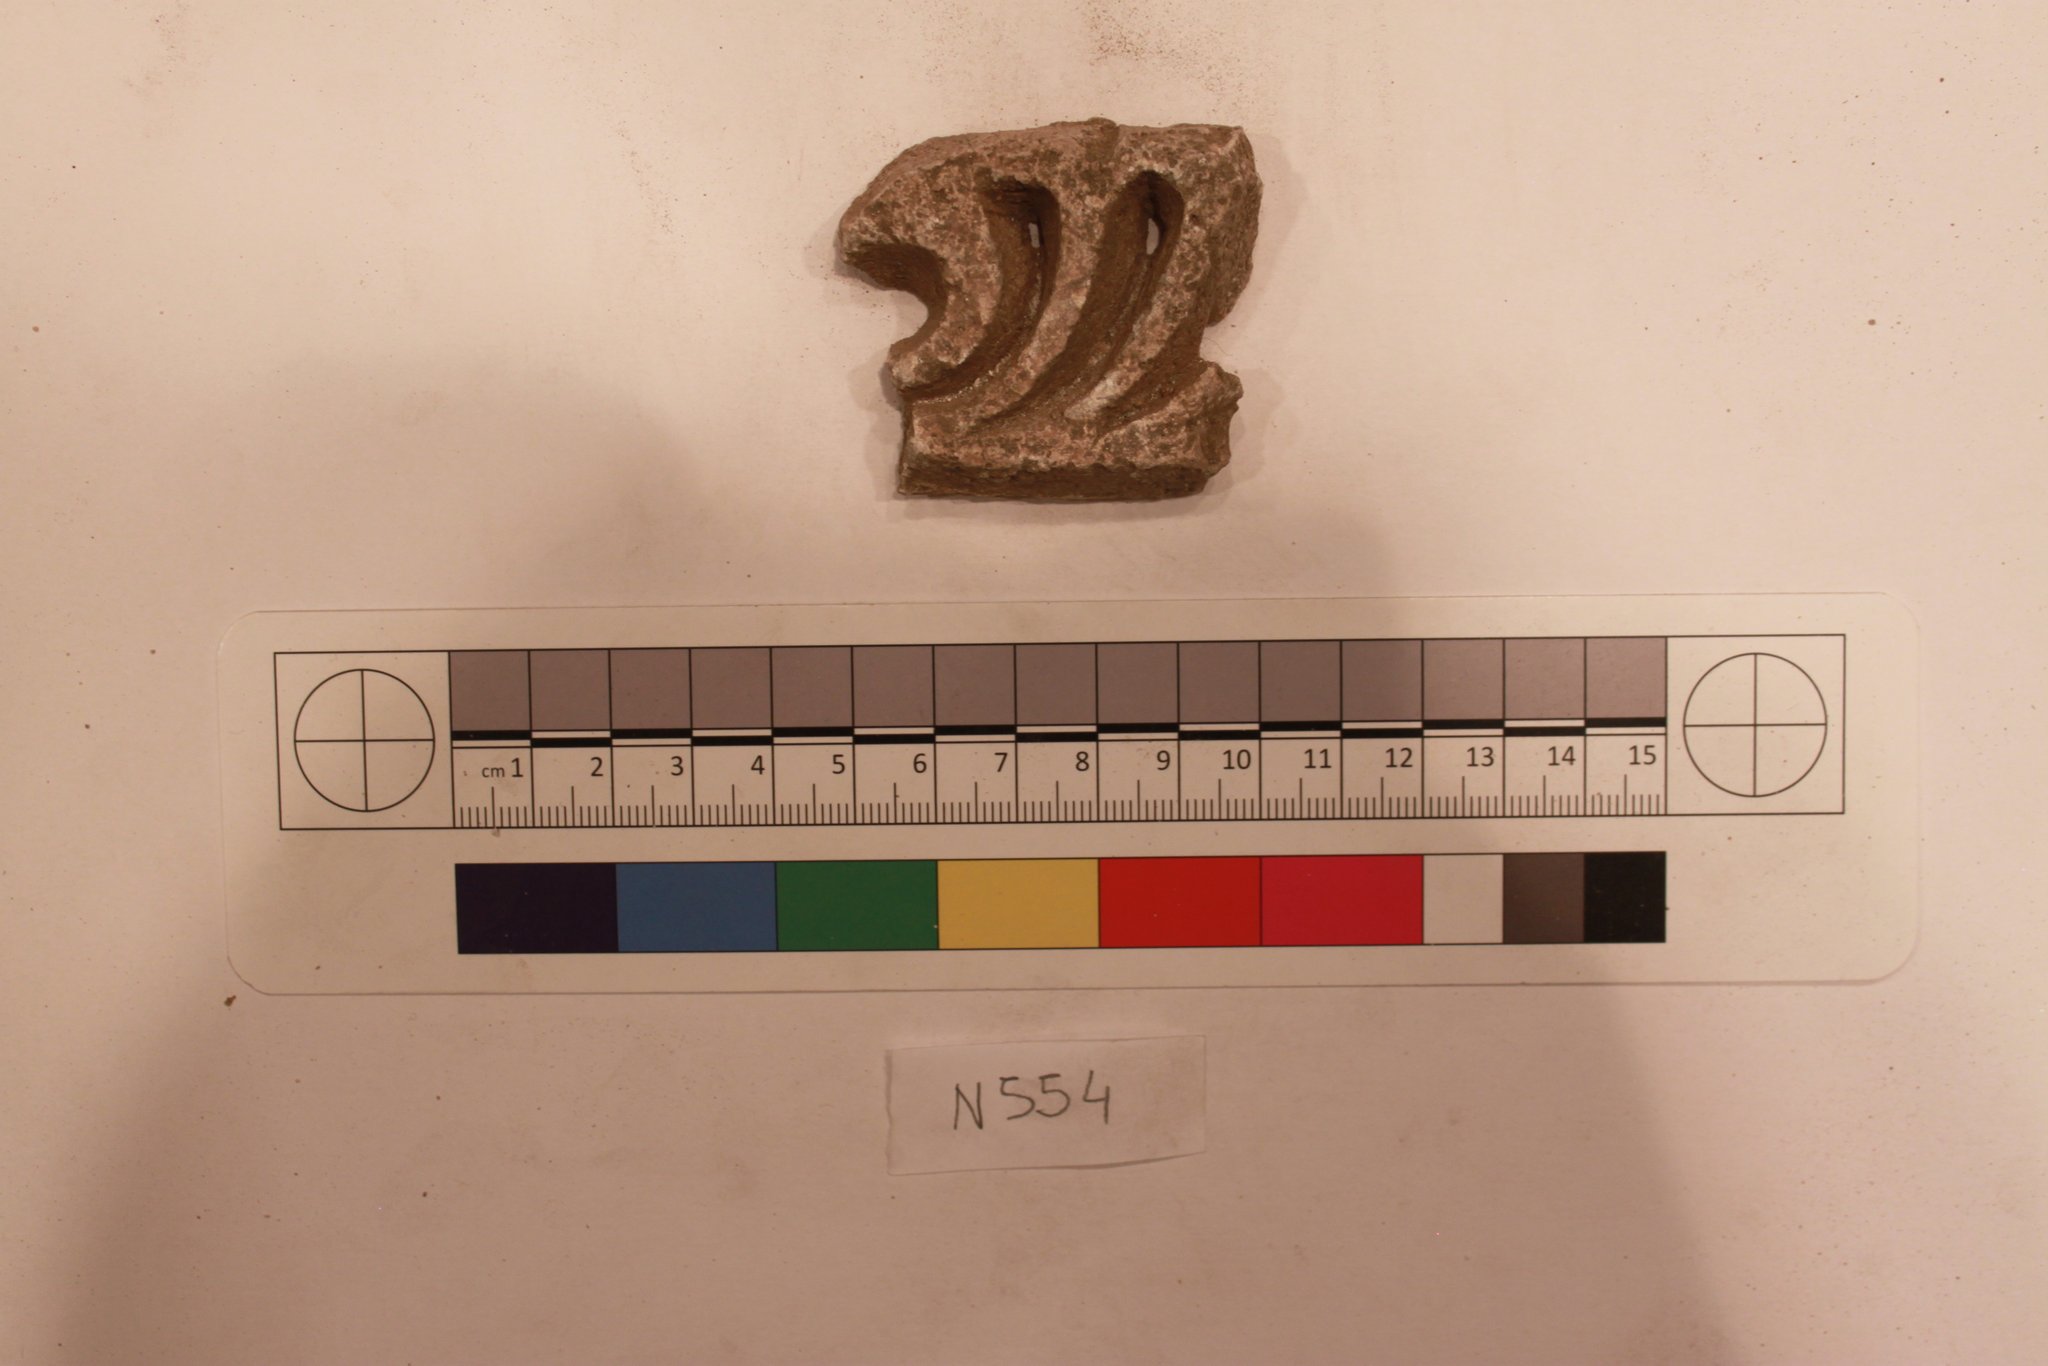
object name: fragment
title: Stucco Fragment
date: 701-1200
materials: plaster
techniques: carving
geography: iran